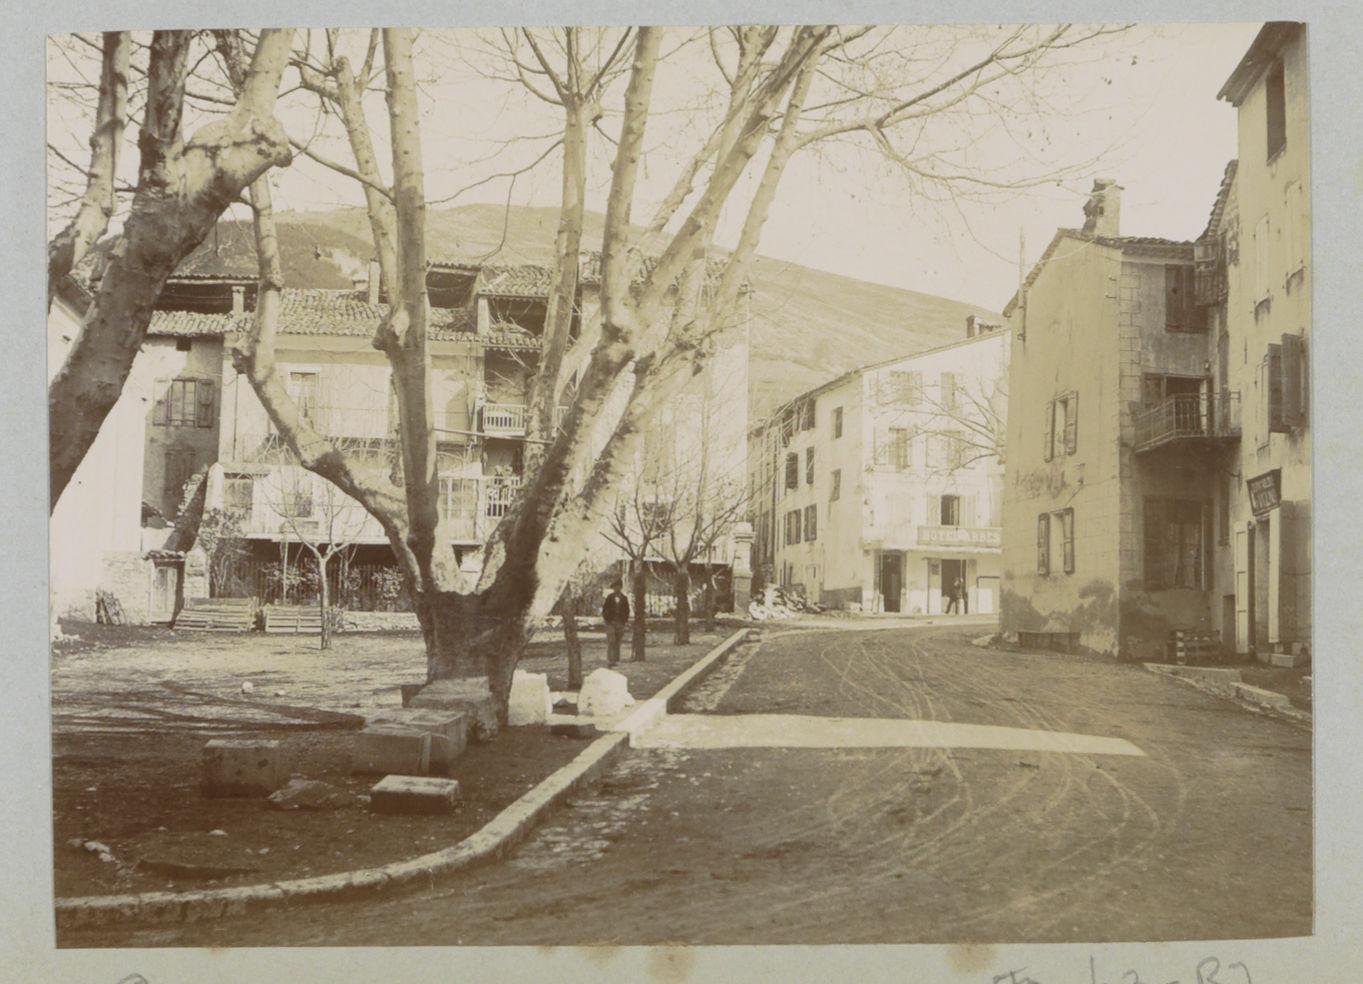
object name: photograph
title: Straatgezicht in Barrême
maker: delizy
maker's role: manufacturer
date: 1903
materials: paper, photographic support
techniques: gelatin silver print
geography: barrême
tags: prospect of village, silhouette of village, square, place, circus, etc. (+ city(-scape) with figures, staffage)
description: Onderdeel van Fotoalbum van een Franse amateurfotograaf met opnames van uitstapjes in Frankrijk, Spanje, België, Luxemburg en Nederland, de eerste automobielen en autoraces.